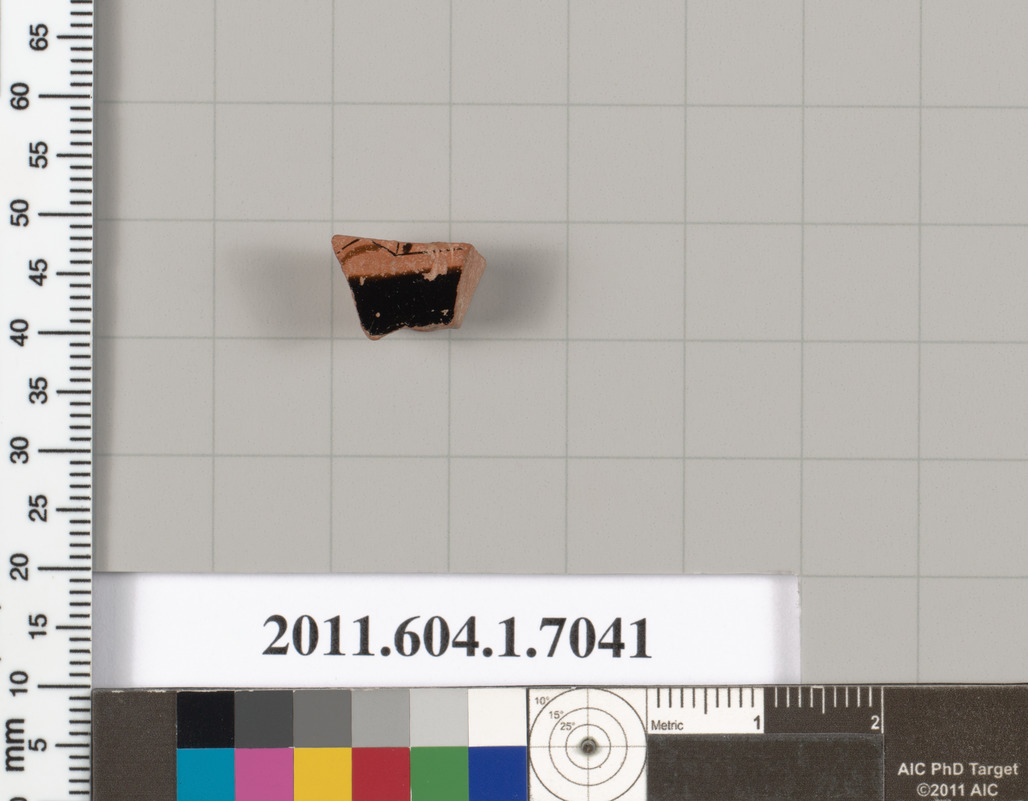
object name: kylix fragment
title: Terracotta fragment of a kylix (drinking cup)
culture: greek, attic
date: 500-480 BCE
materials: terracotta